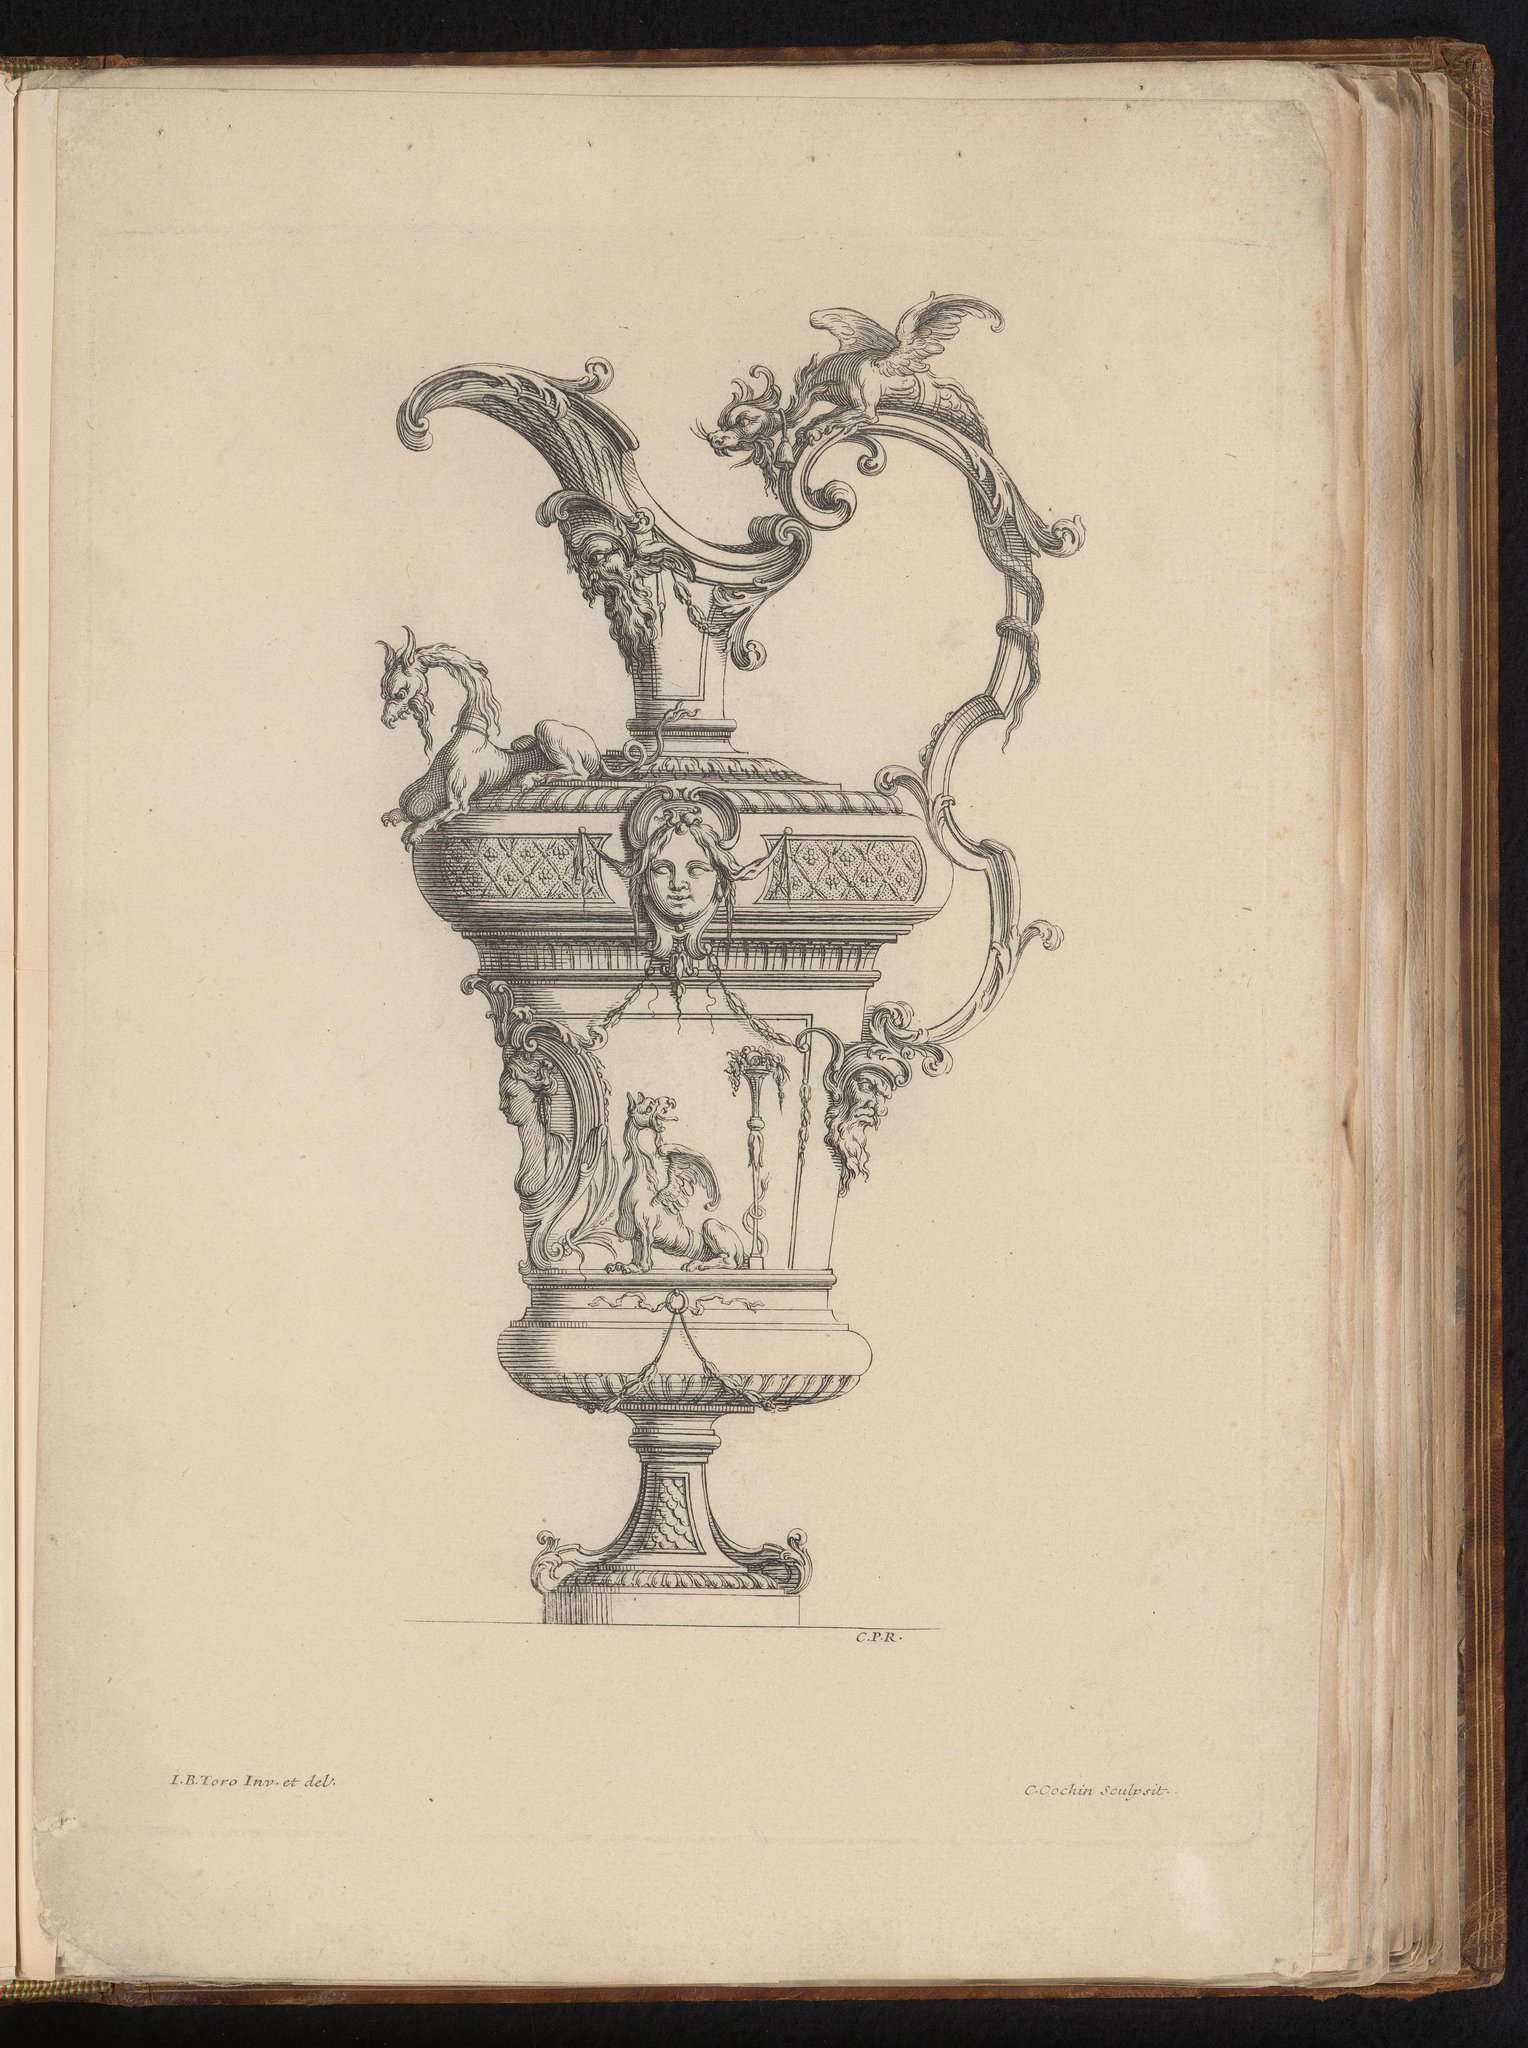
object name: print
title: Ontwerpen voor ornamenten met vazen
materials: paper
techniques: engraving, etching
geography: paris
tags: fabulous animals (sometimes wrongly called 'grotesques'); 'mostri' (ripa), vase ~ ornament, mask, mascaron ~ ornament, container of ceramics: jar, jug, pot, vase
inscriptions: collector's mark: Lugt 2760, collector's mark: Lugt 2228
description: Prent maakt deel uit van een serie van zeven prenten.